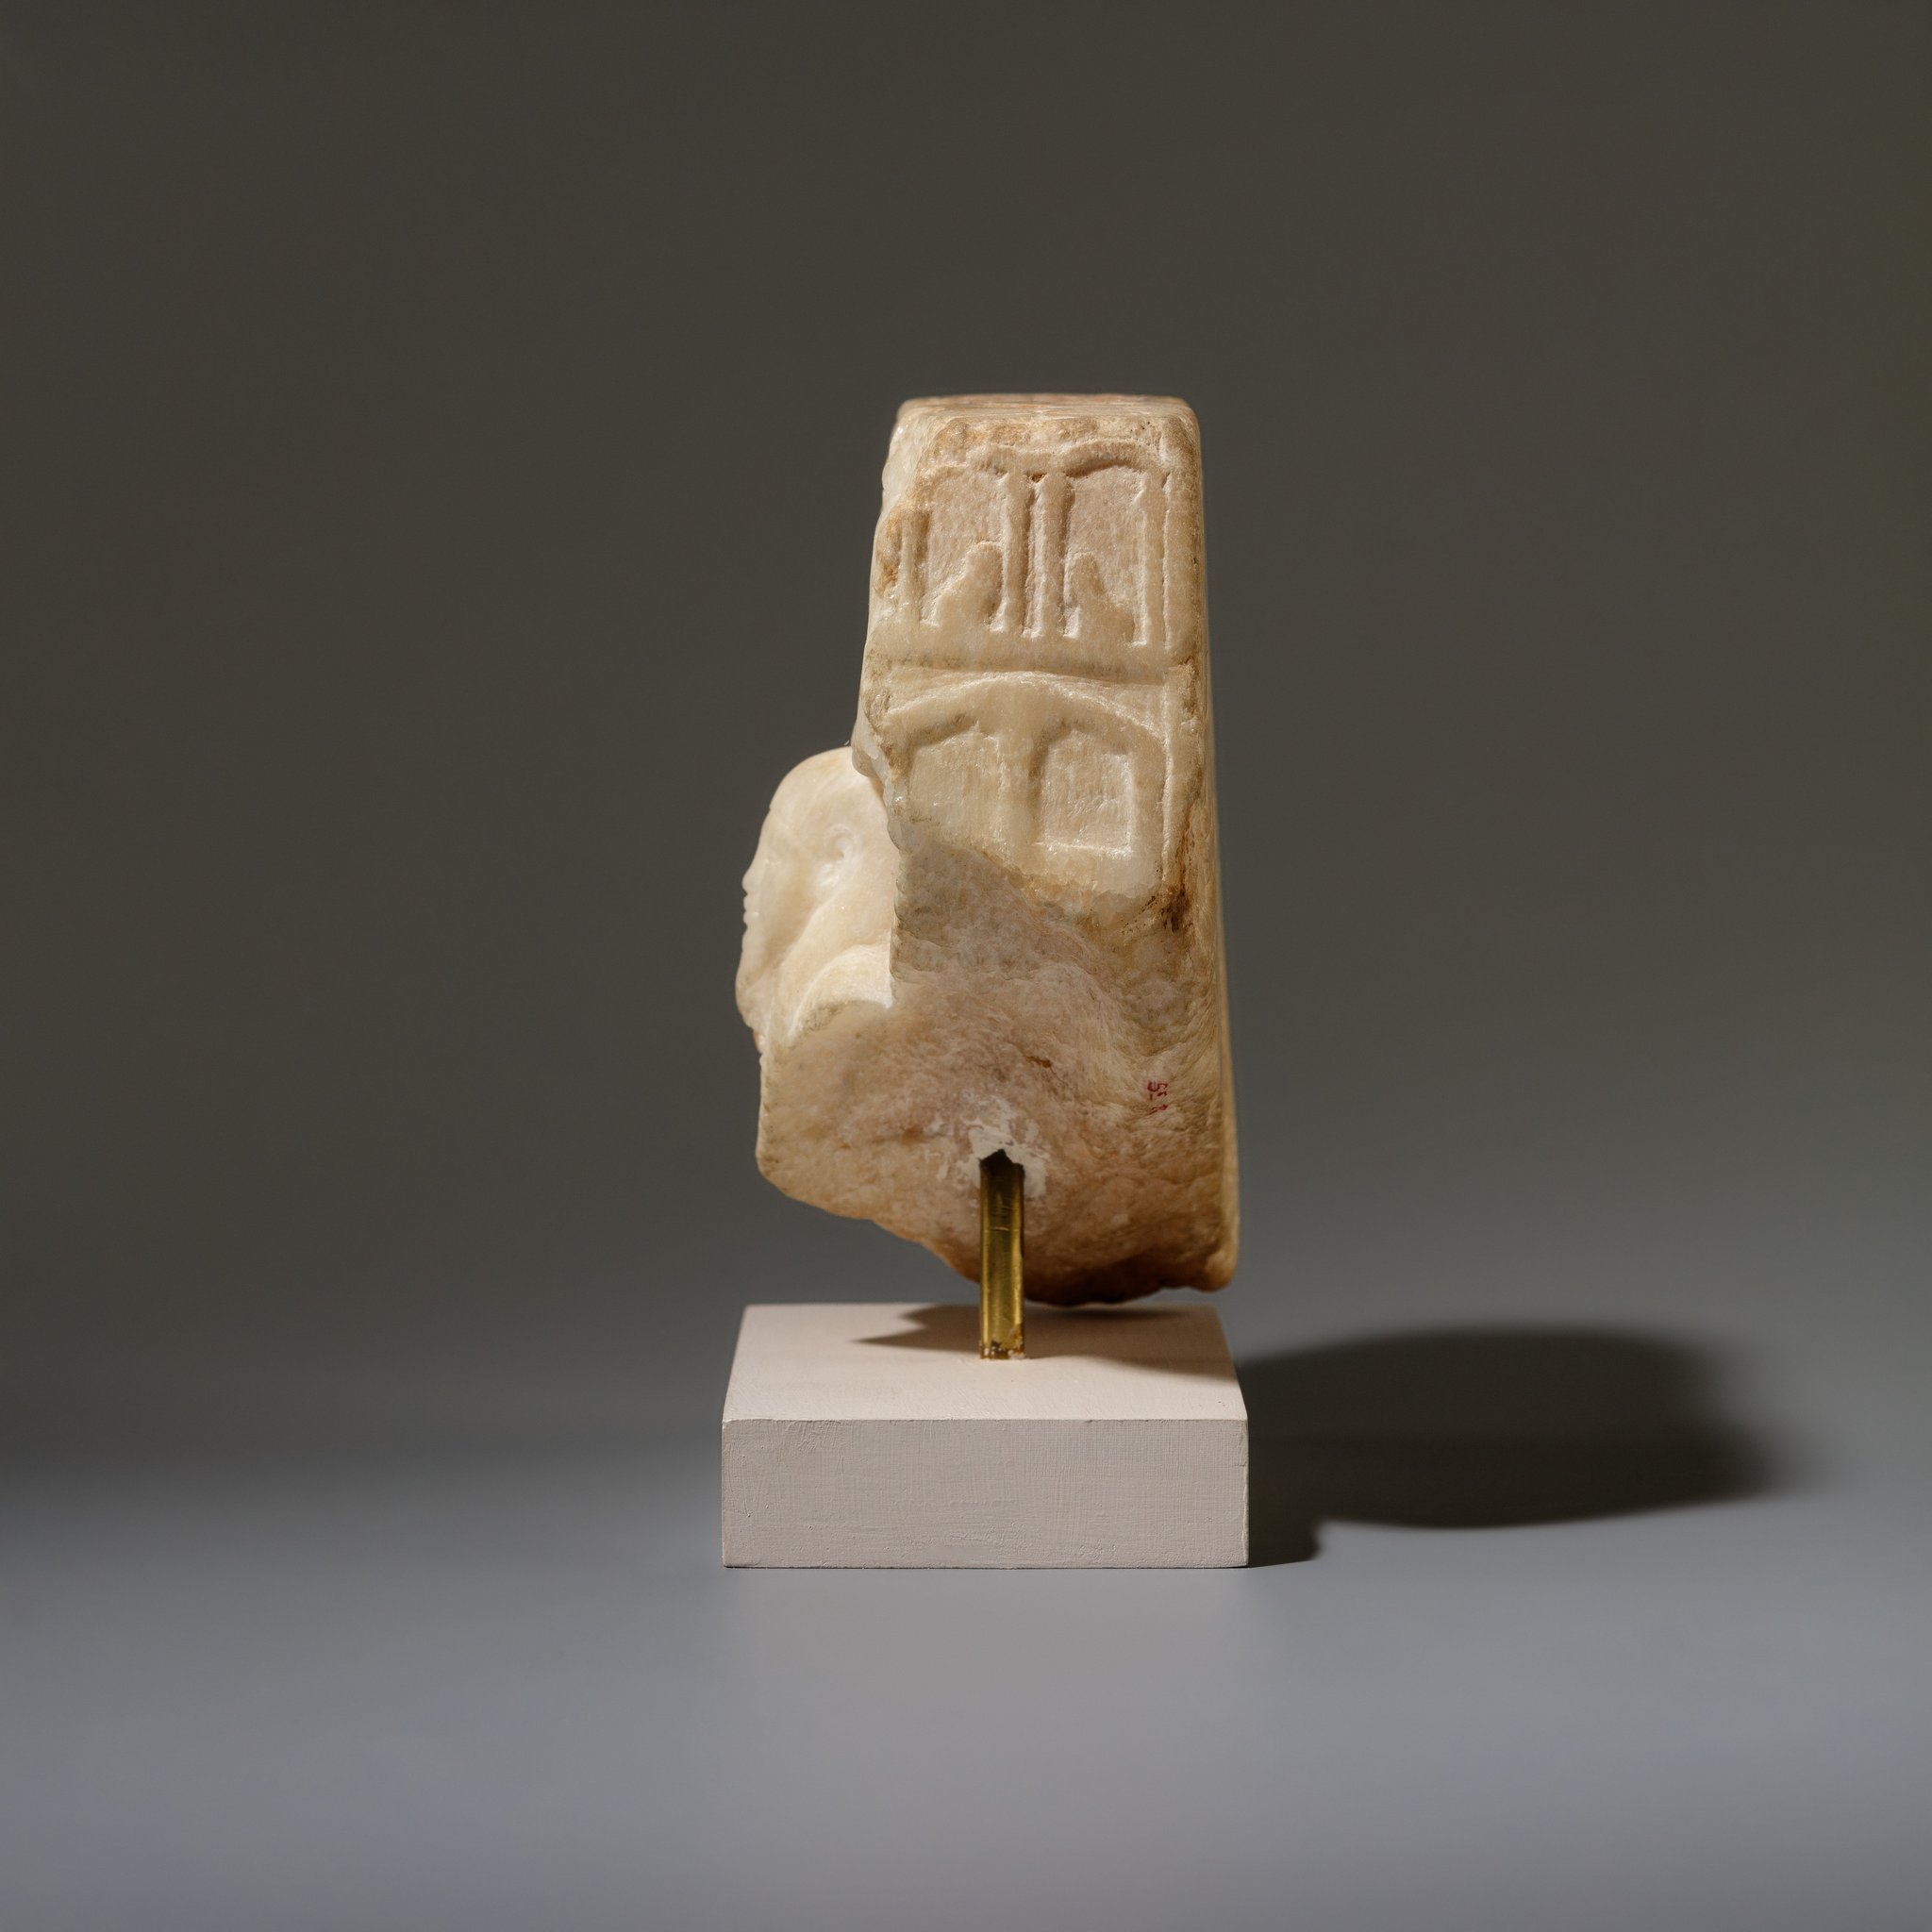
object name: stela, heb sed of amenhotep iii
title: Stela of the Heb Sed of Amenhotep III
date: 1390-1353 BCE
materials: stone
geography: egypt